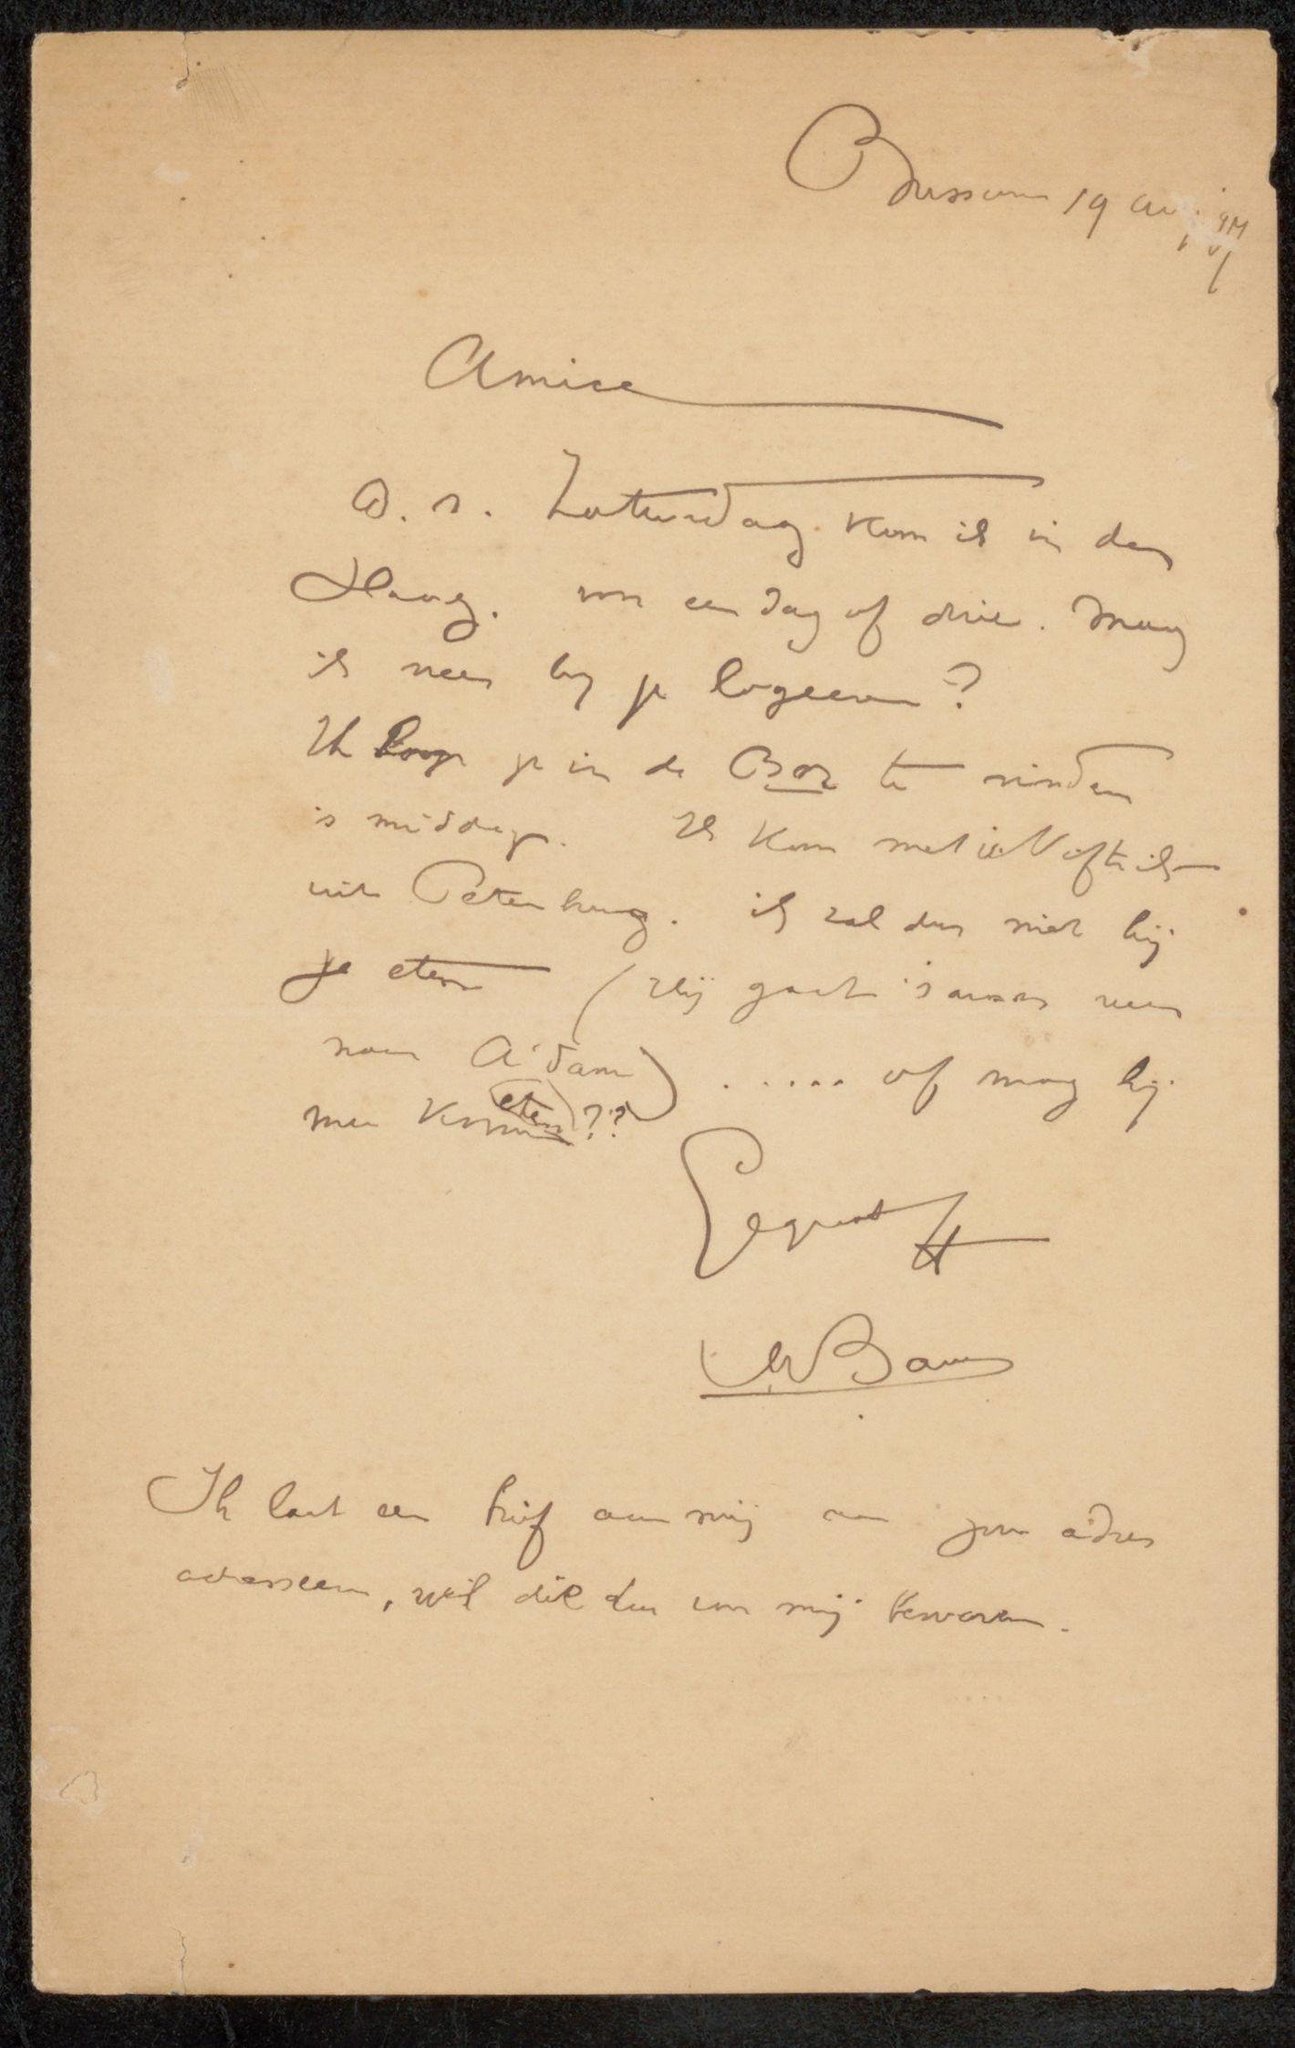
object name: letter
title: Brief aan Philip Zilcken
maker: marius bauer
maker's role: draughtsman, print maker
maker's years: 1867-1932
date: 1897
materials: ink, paper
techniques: pen, writing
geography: bussum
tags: the hague, painter, draughtsman, philip zilcken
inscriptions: collector's mark: ‘RPK’